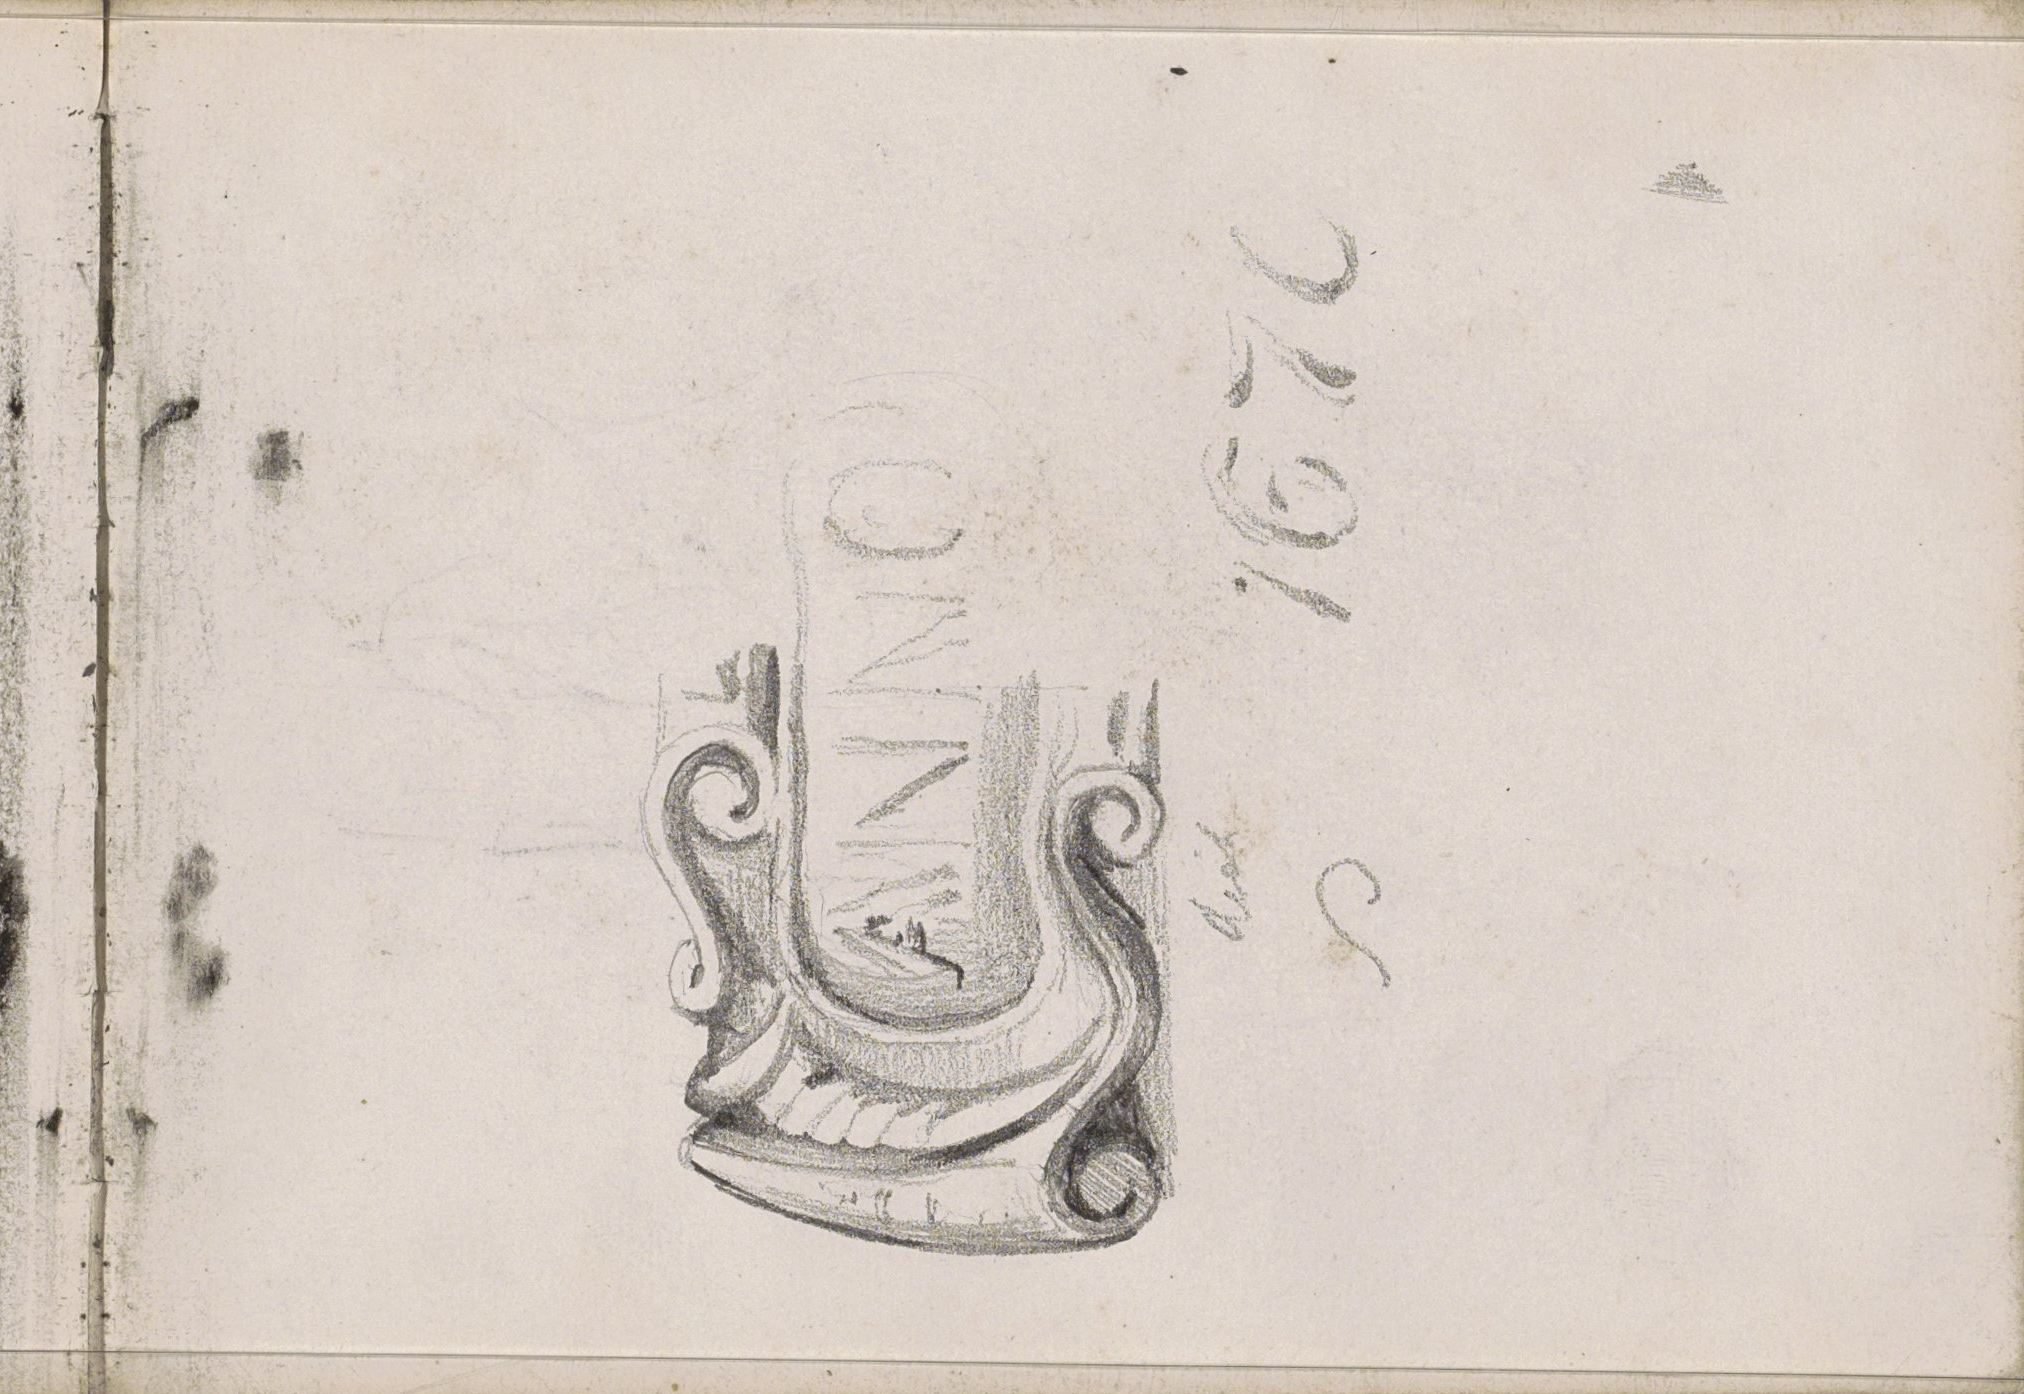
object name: sketchbook leaf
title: Gevelsteen met jaartal in cartouche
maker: jac van looij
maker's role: draughtsman, painter, print maker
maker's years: 1855-1930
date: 1877-1880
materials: paper, pencil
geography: amsterdam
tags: stone tablet in façade, ribbon, scroll, banderole ~ ornament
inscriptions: annotation: ‘di[...]/ 1670’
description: Blad 26 recto uit een schetsboek met 27 bladen.